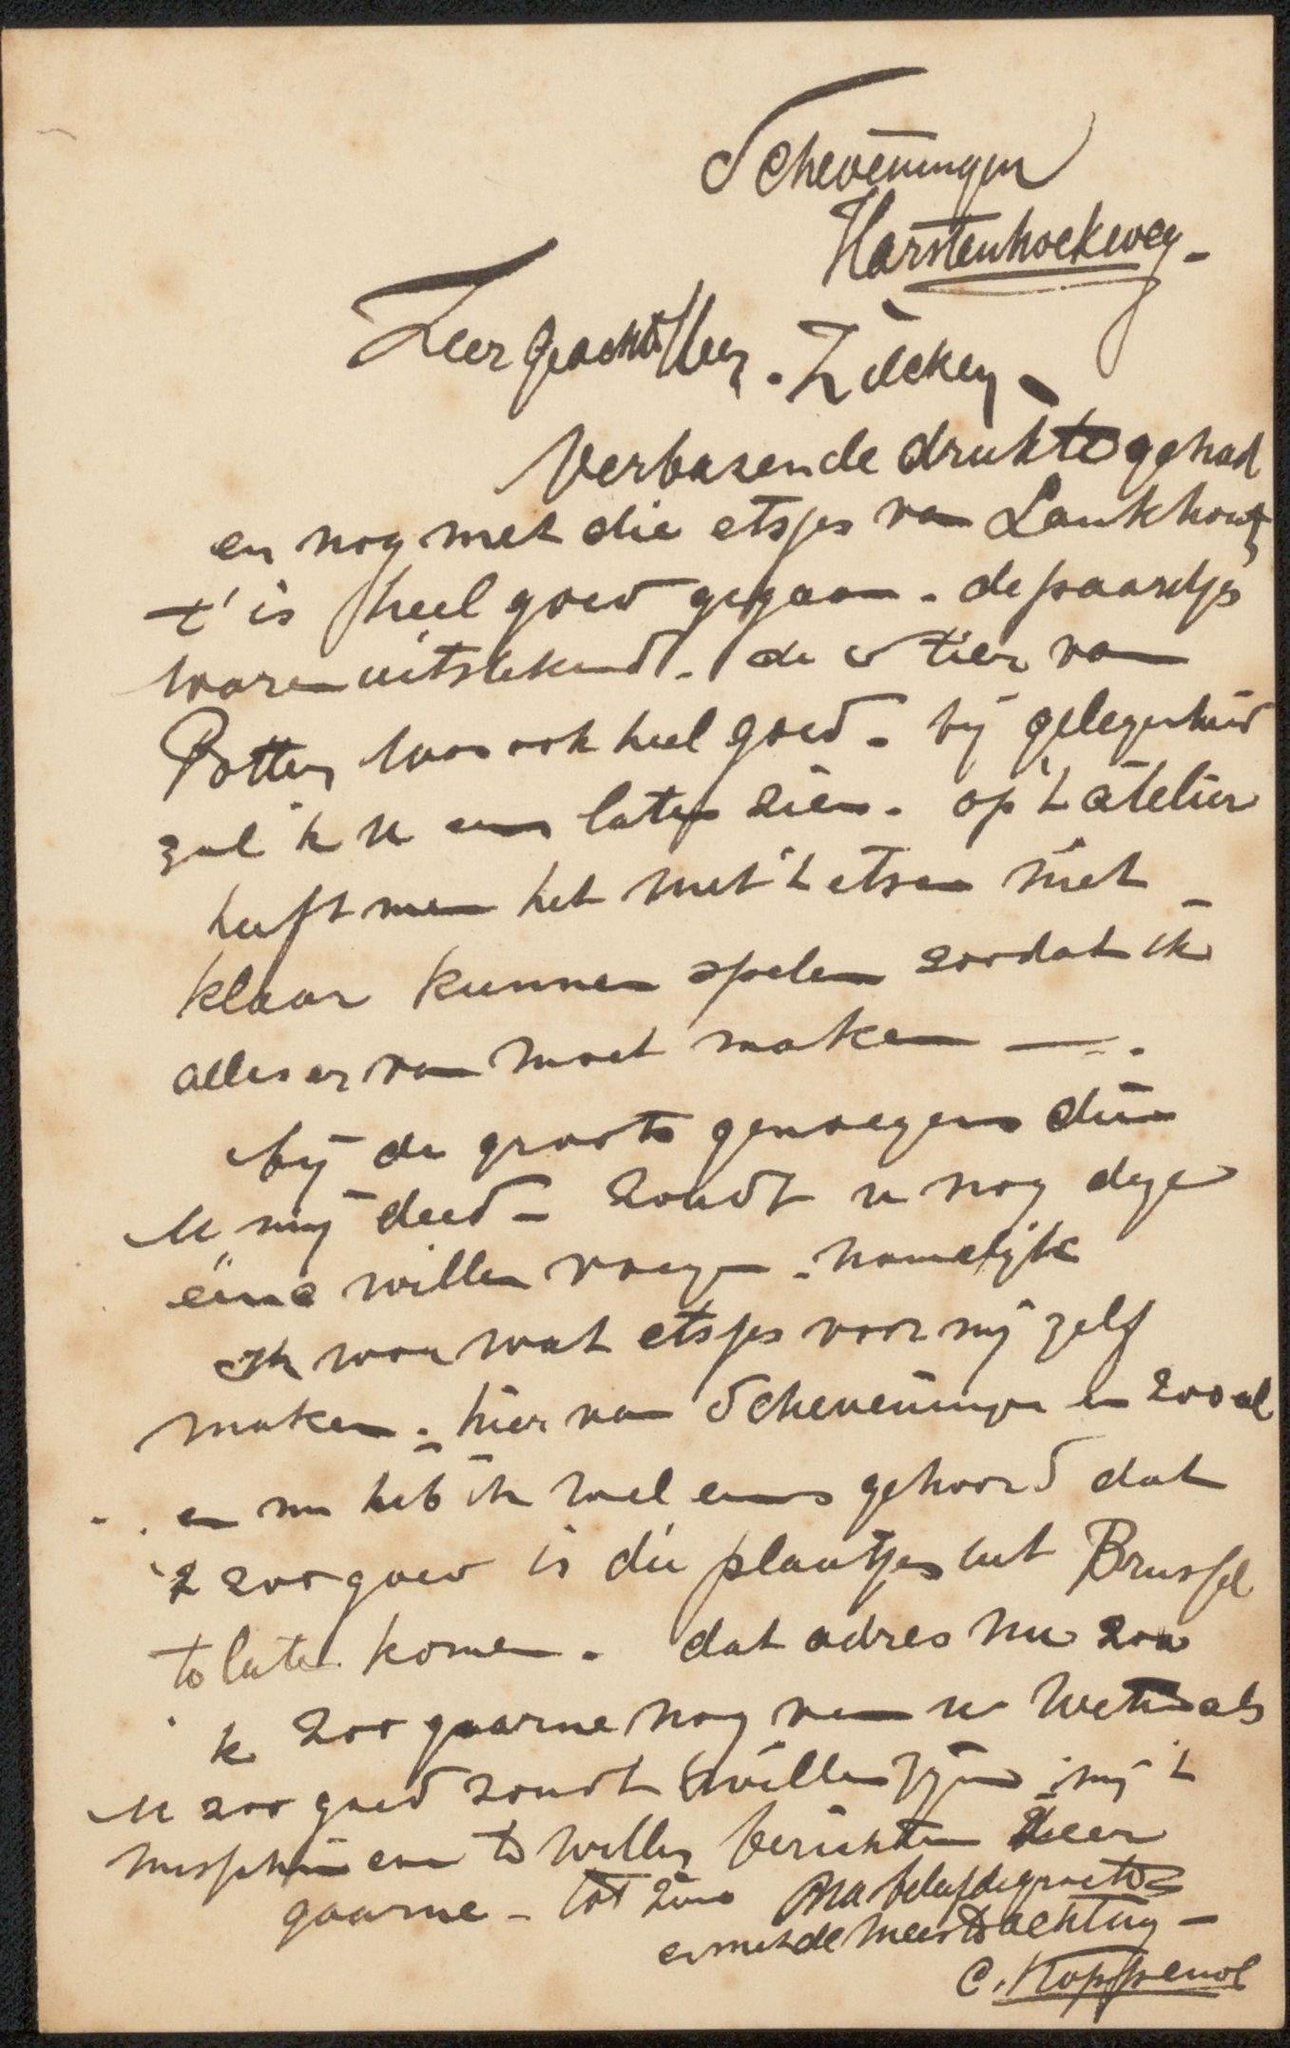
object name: letter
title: Brief aan Philip Zilcken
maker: cornelis koppenol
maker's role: print maker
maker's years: 1865-1946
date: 1875-1930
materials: ink, paper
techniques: pen, writing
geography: scheveningen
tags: painter, draughtsman, philip zilcken, the graphic arts, brussels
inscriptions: collector's mark: ‘RPK’